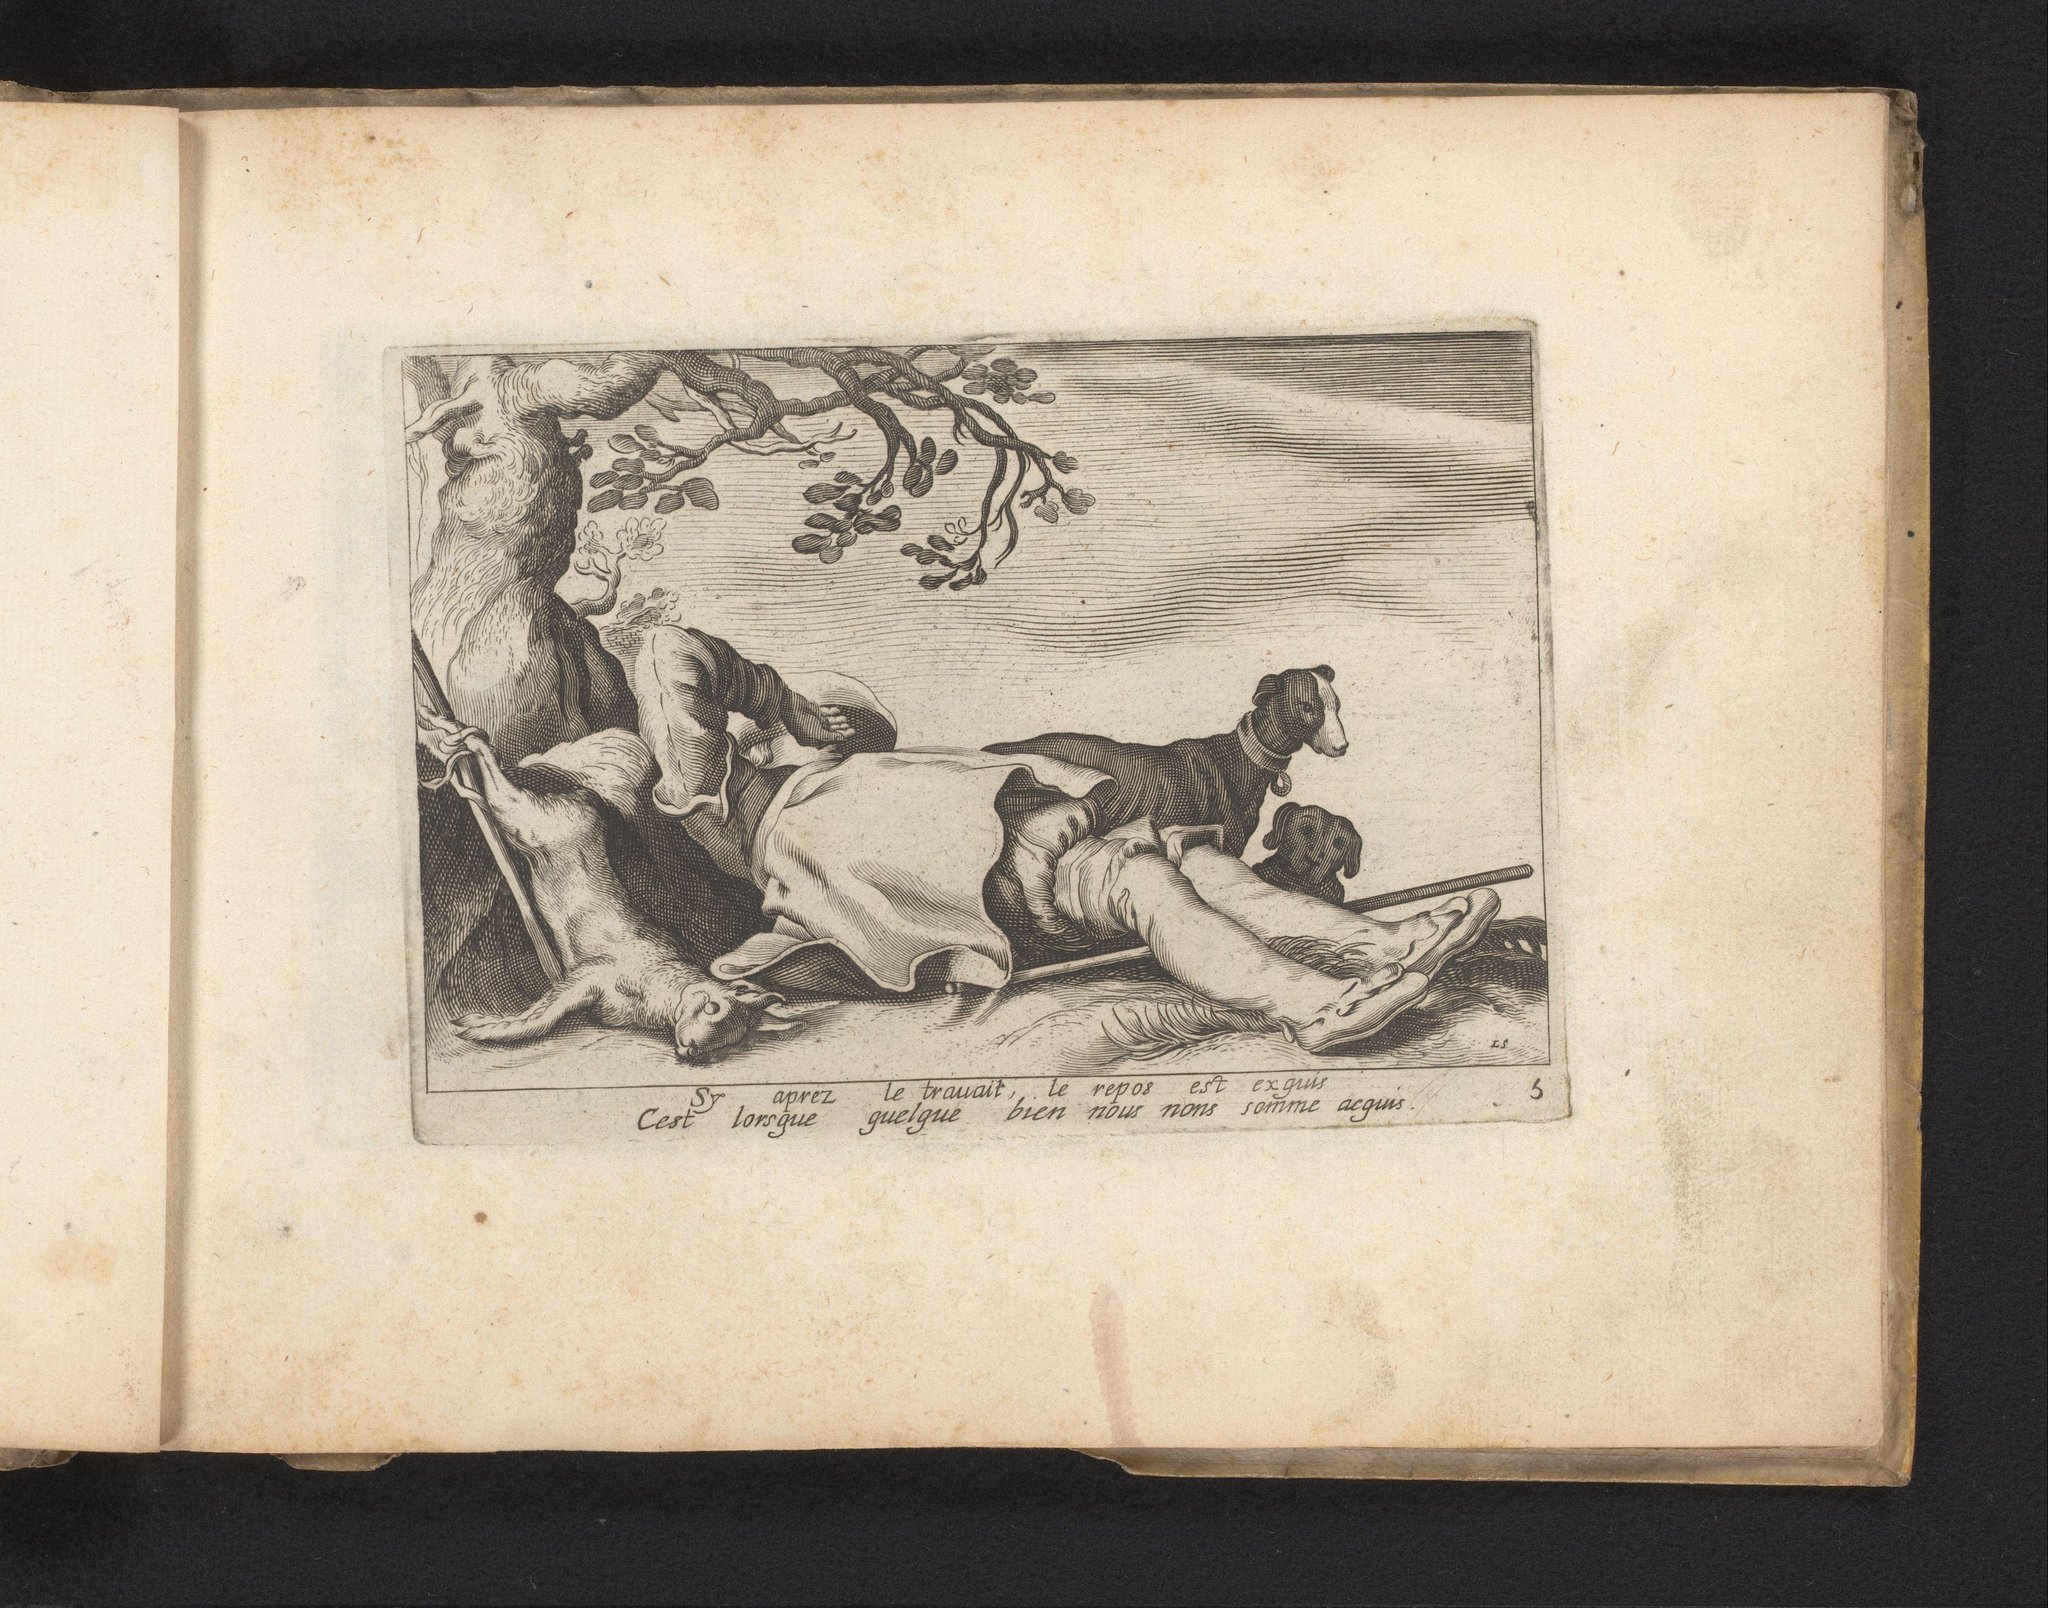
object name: album leaf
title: Jager met twee honden slaapt bij een gevangen haas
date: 1606-1669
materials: paper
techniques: etching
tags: rodents: hare, sleeping on the ground - bb - out of doors, hunting dogs beside the spoils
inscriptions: collector's mark: ‘Bibliotheek/ Rijksmuseum/ Amsterdam’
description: Deze prent maakt deel uit van een album.